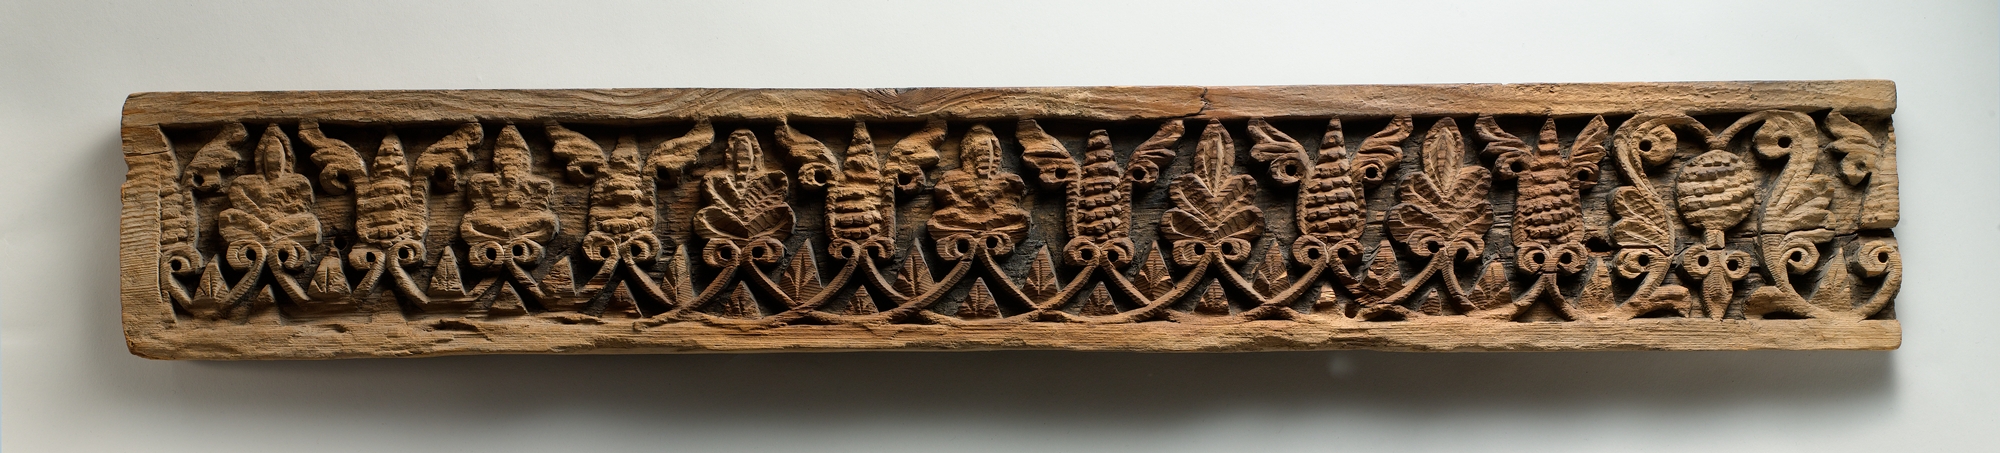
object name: panel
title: Fragment of a Frieze with Winged Pinecones and Palmettes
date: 701-900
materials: wood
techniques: carving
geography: possibly eastern mediterranean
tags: palmettes,pinecones